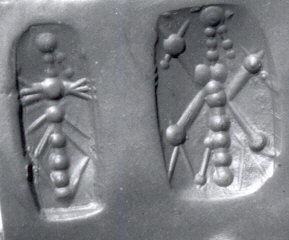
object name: stamp seal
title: Stamp seal (cubical) with three-figure contests and divine beings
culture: assyro-babylonian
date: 700-501 BCE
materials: stone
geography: mesopotamia